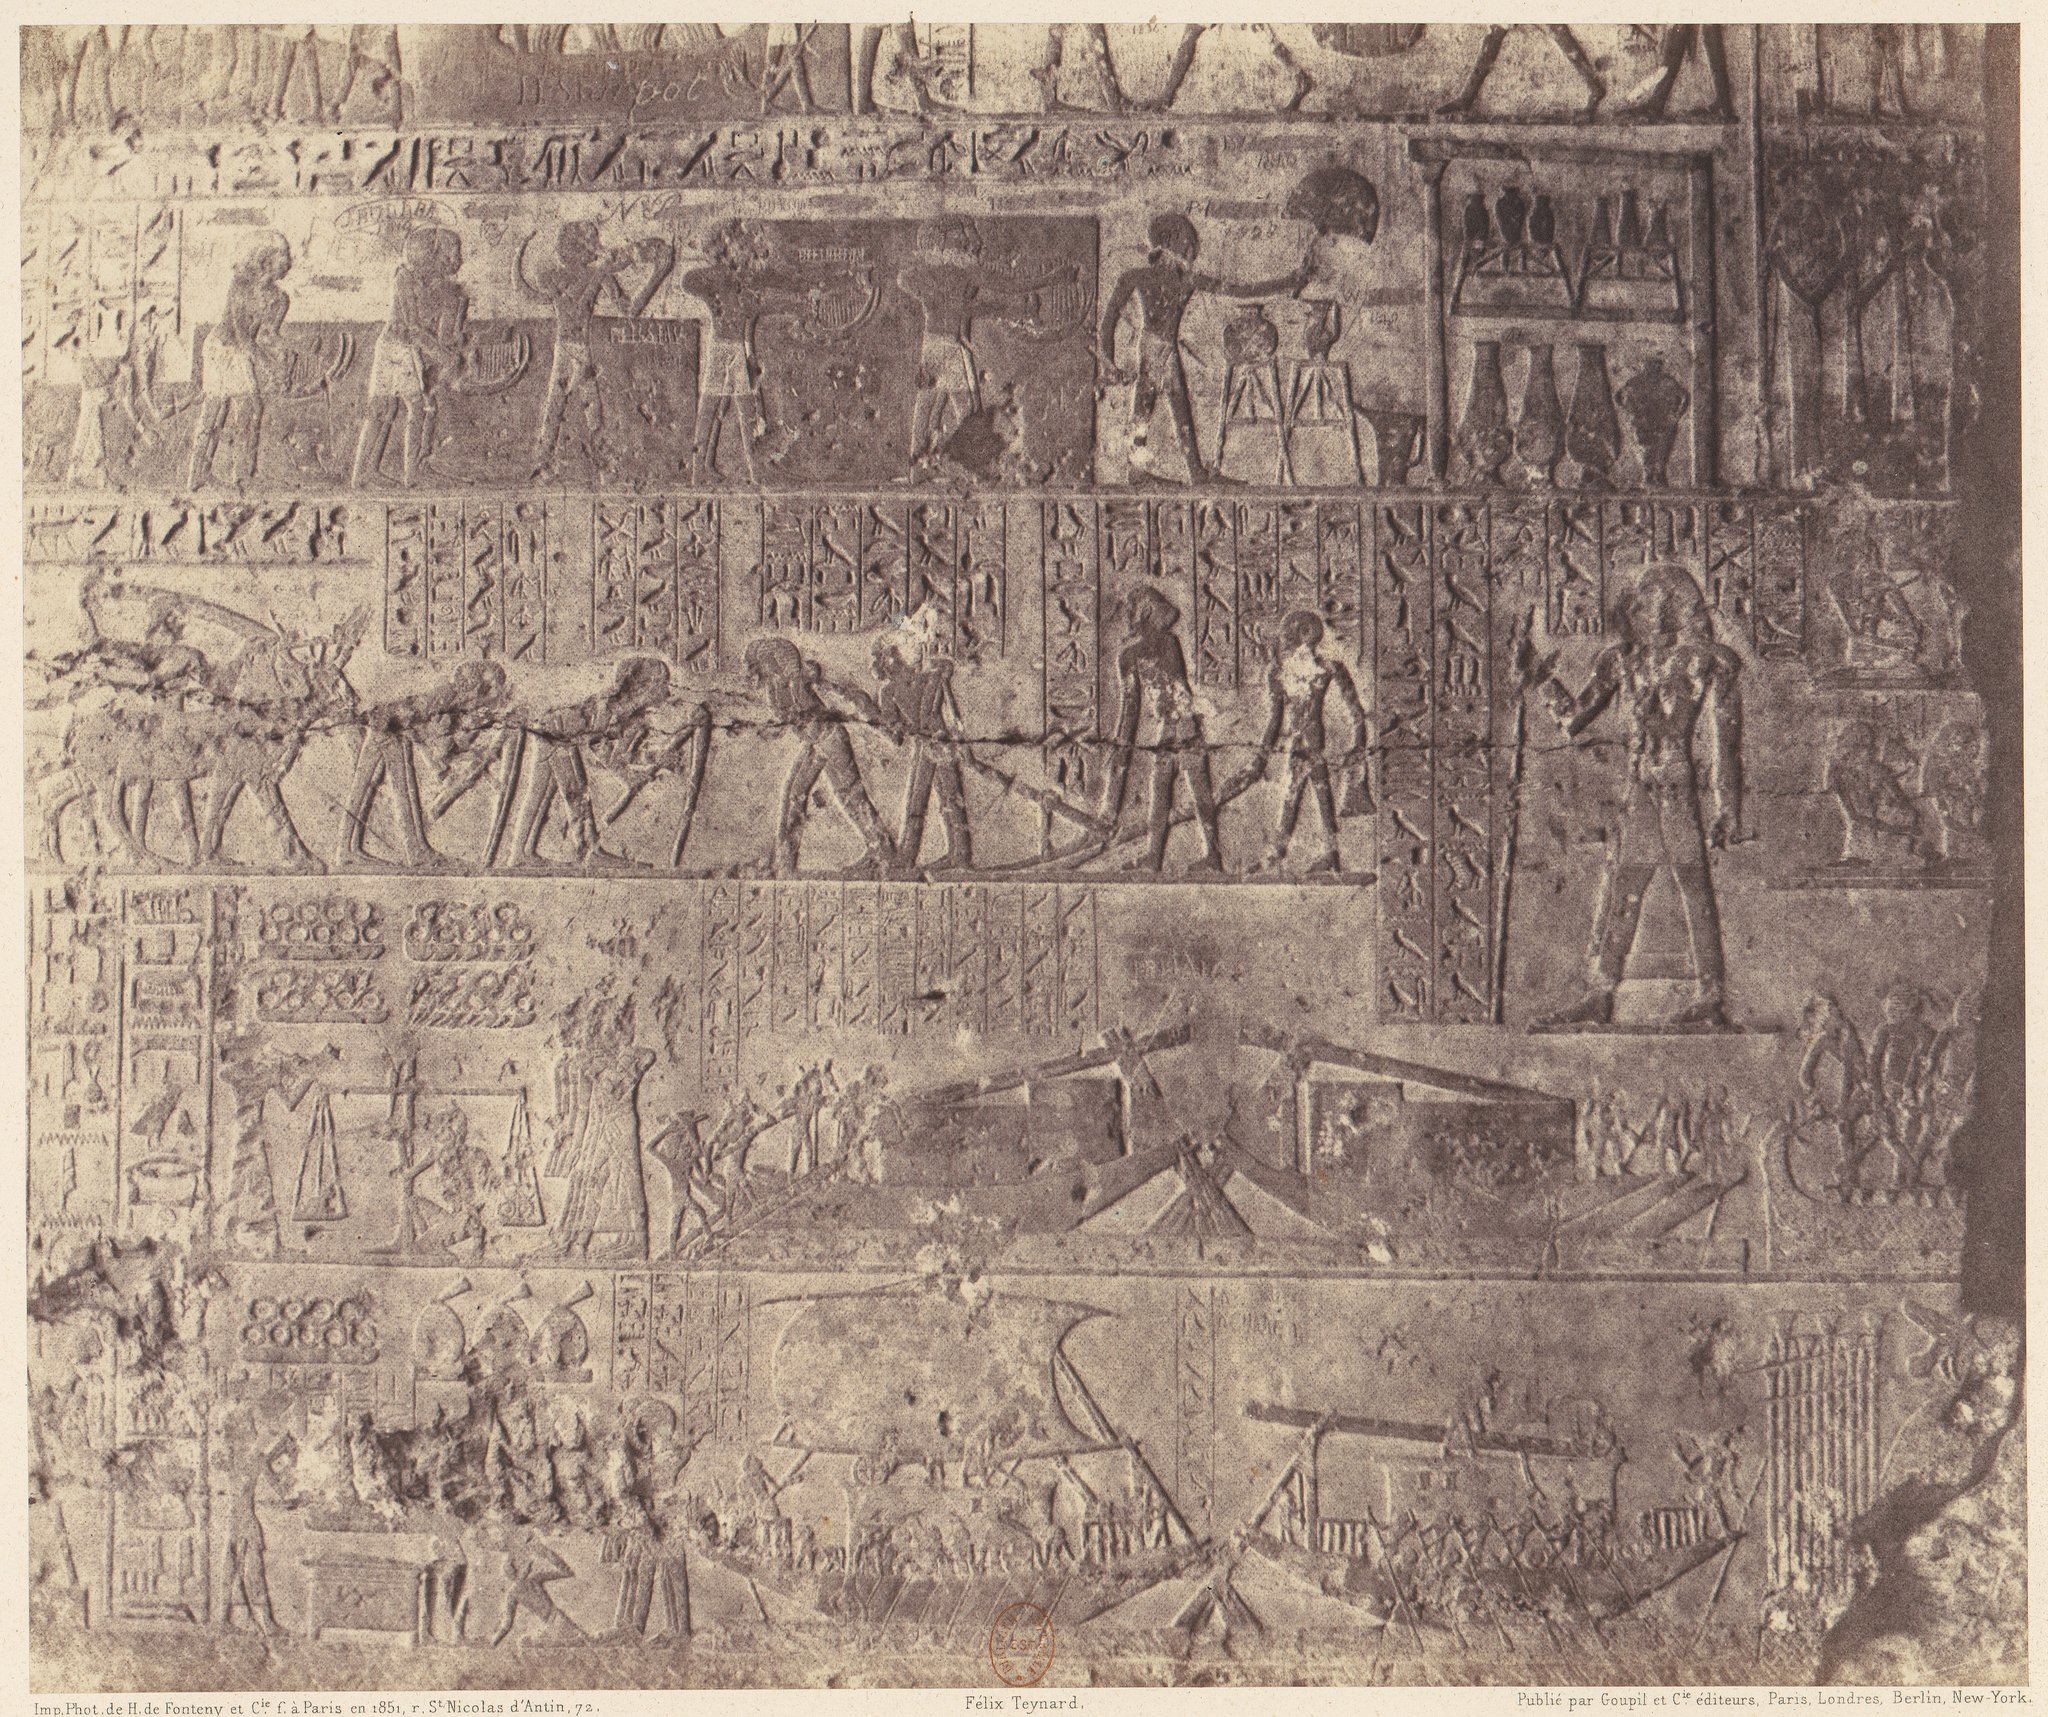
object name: photograph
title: El-Kab (Éléthya), Architecture Hypogéenne - Tombeau de Phapé - Sculptures Pientes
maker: félix teynard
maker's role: artist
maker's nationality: french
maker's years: 1817-1892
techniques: paper negative, salted paper print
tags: sculpture,hieroglyphs